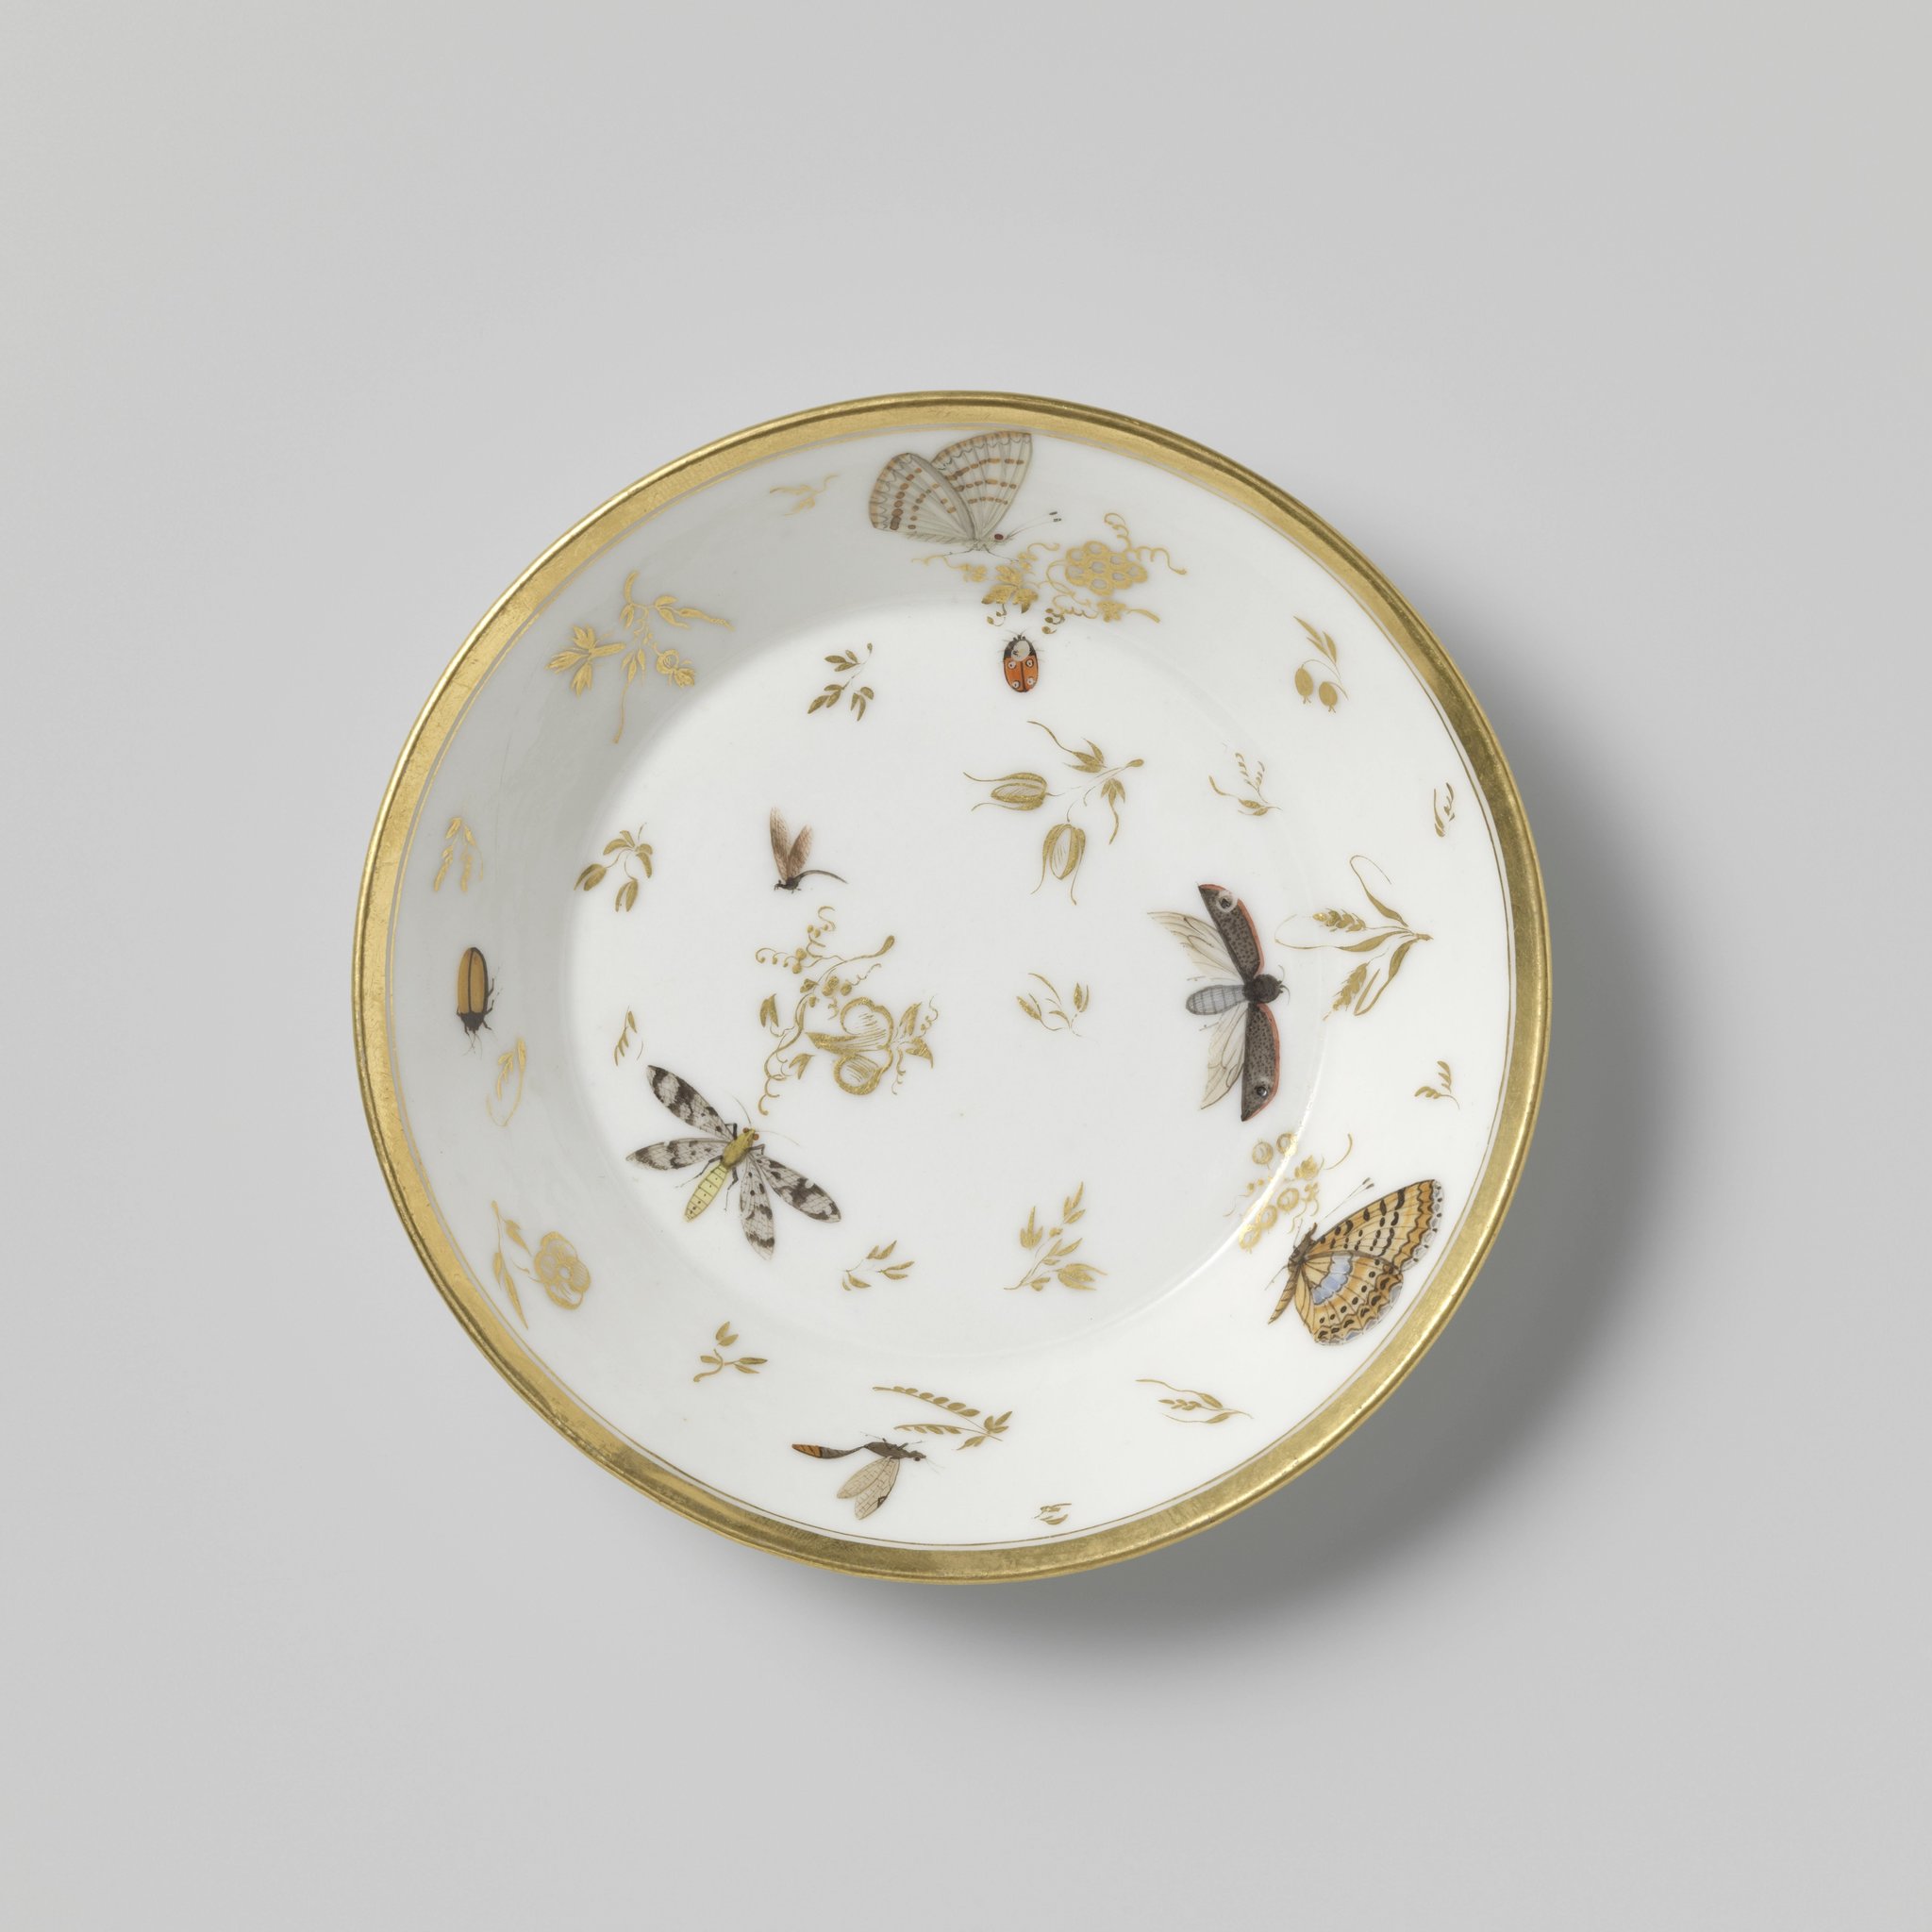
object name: service set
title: Saucer with insects, flower sprays and grapevines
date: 1797-1798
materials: glaze, gold, paint, porcelain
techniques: firing, forming, gilding, turning, vitrification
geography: paris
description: Schotel van porselein met een rechte wand, beschilderd op het glazuur in emailkleuren en goud. De voorzijde is bedekt met gekleurde insecten (vlinders, kevers, libellen, etc.) en in goud bloemtakken en druivenranken. Gouden rand.